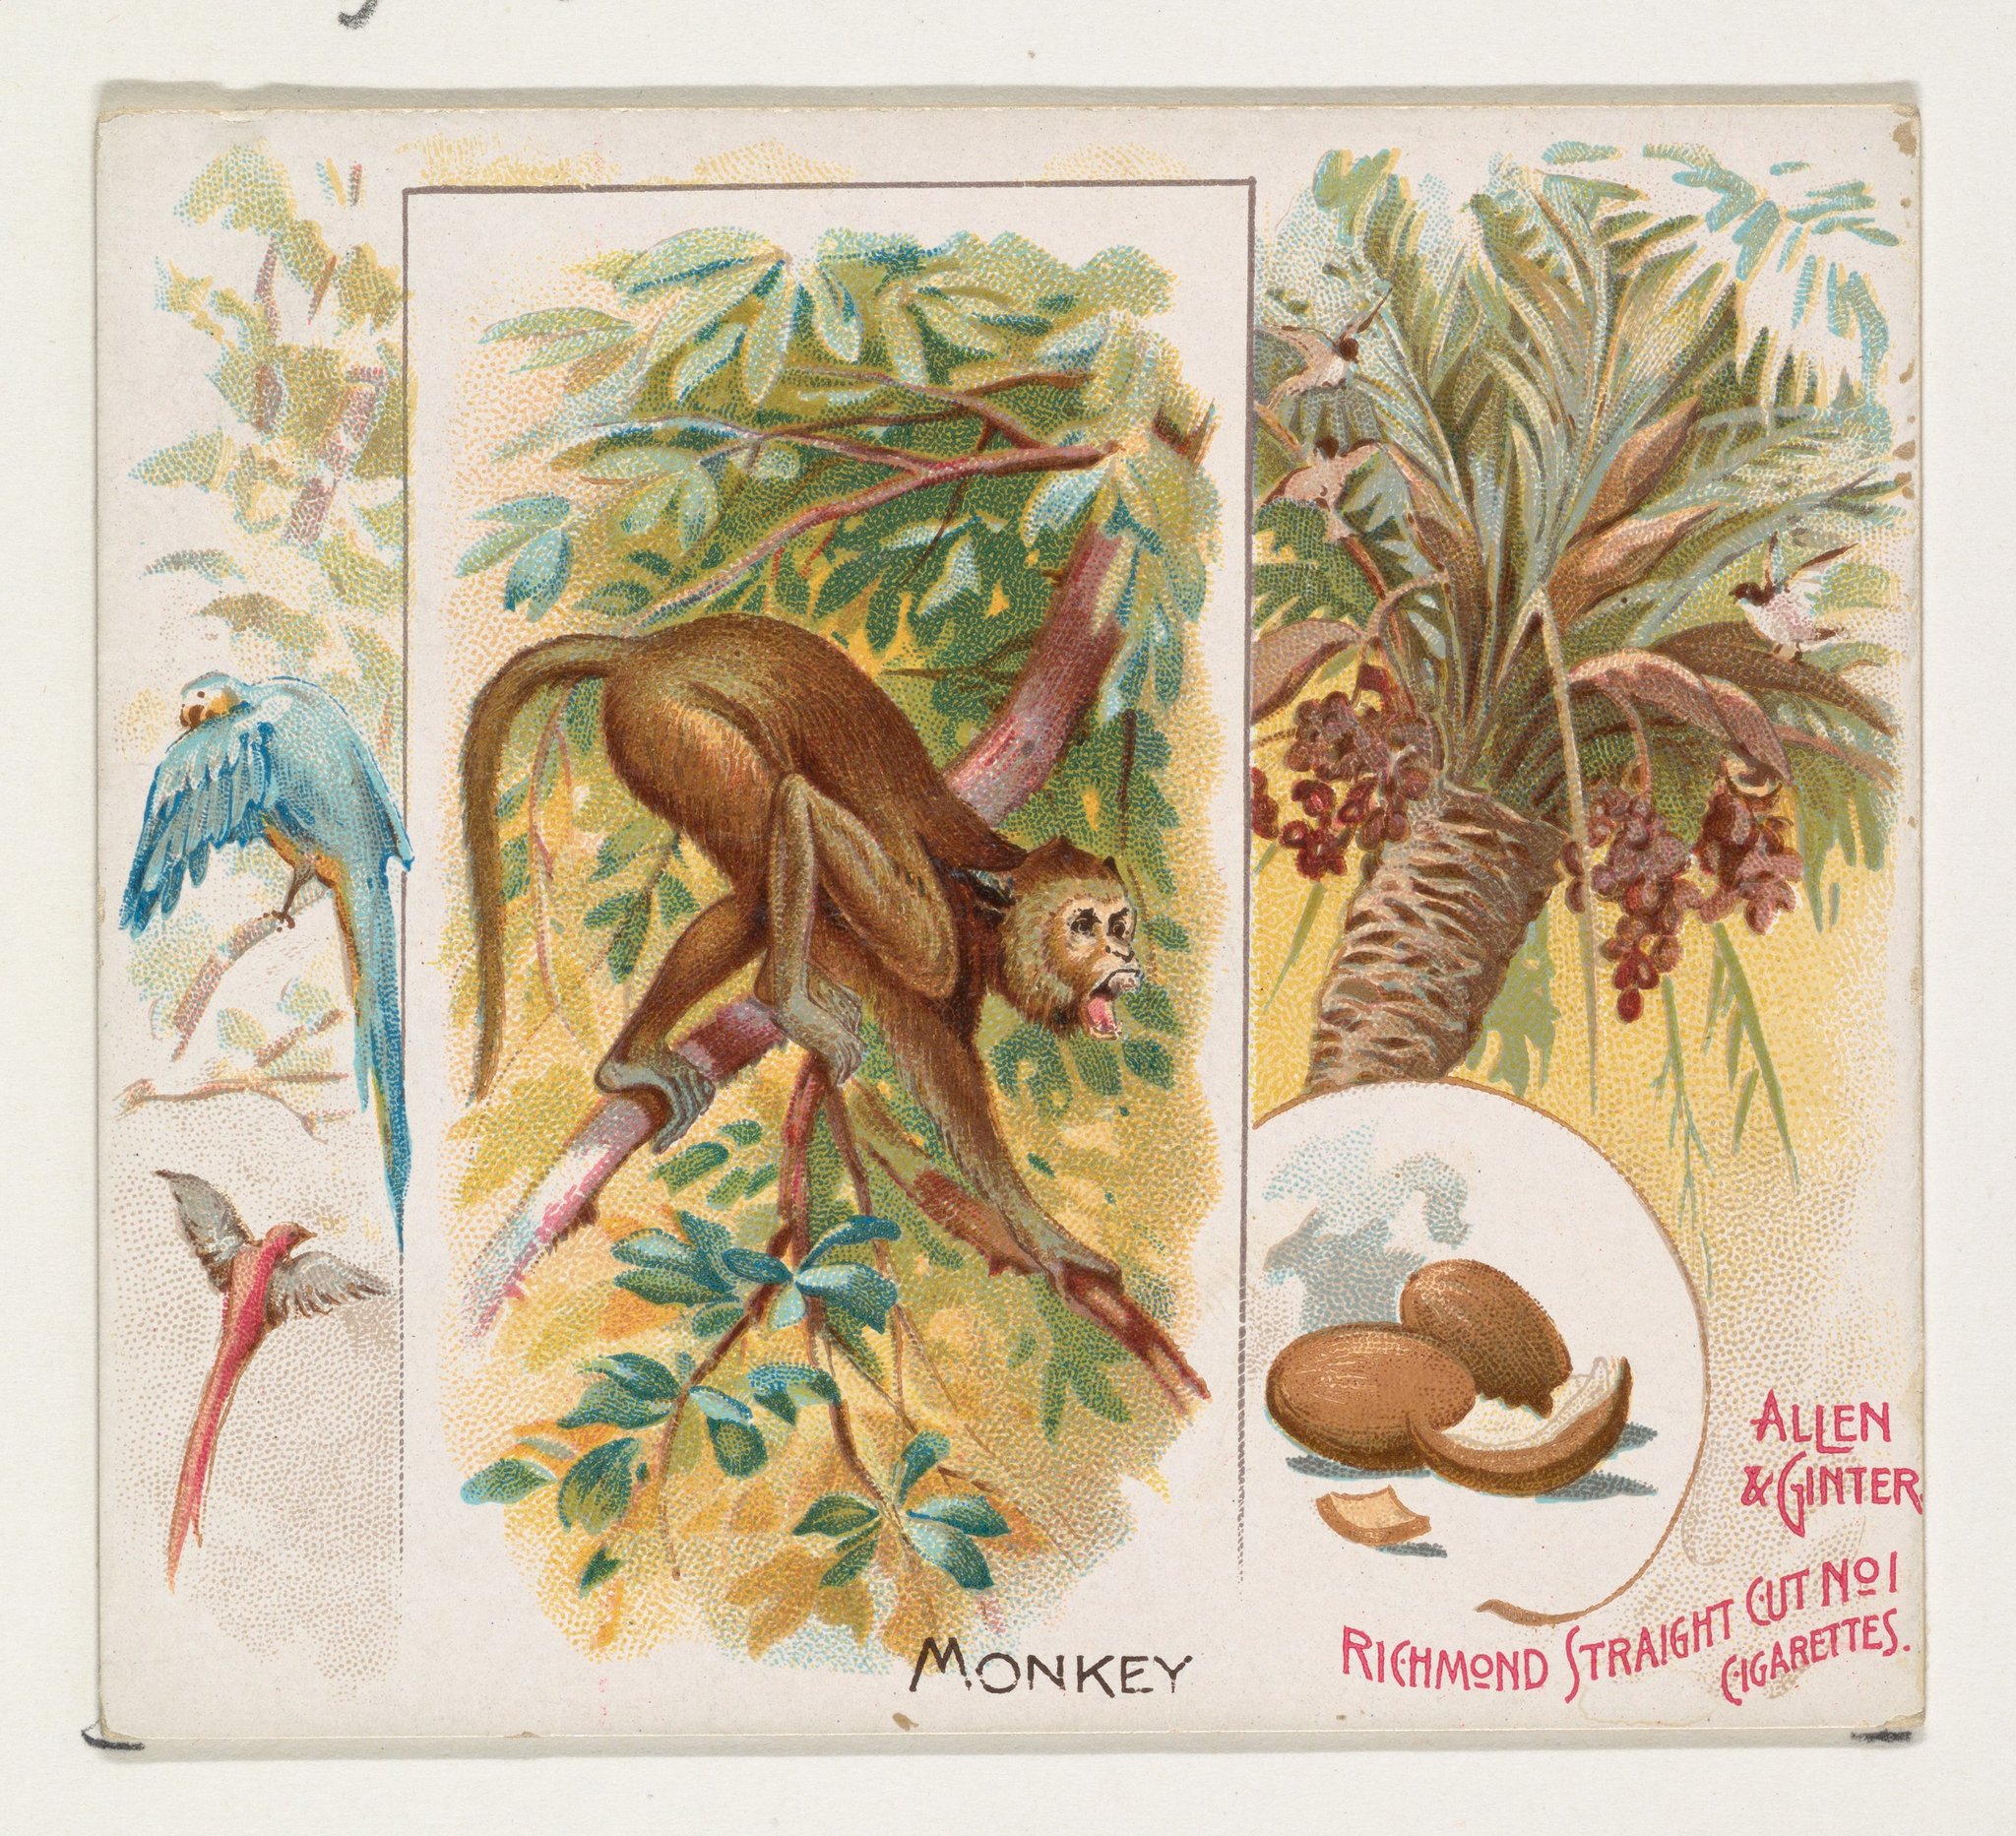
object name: print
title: Monkey, from Quadrupeds series (N41) for Allen & Ginter Cigarettes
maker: allen & ginter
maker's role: publisher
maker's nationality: american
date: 1890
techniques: color lithograph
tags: monkeys